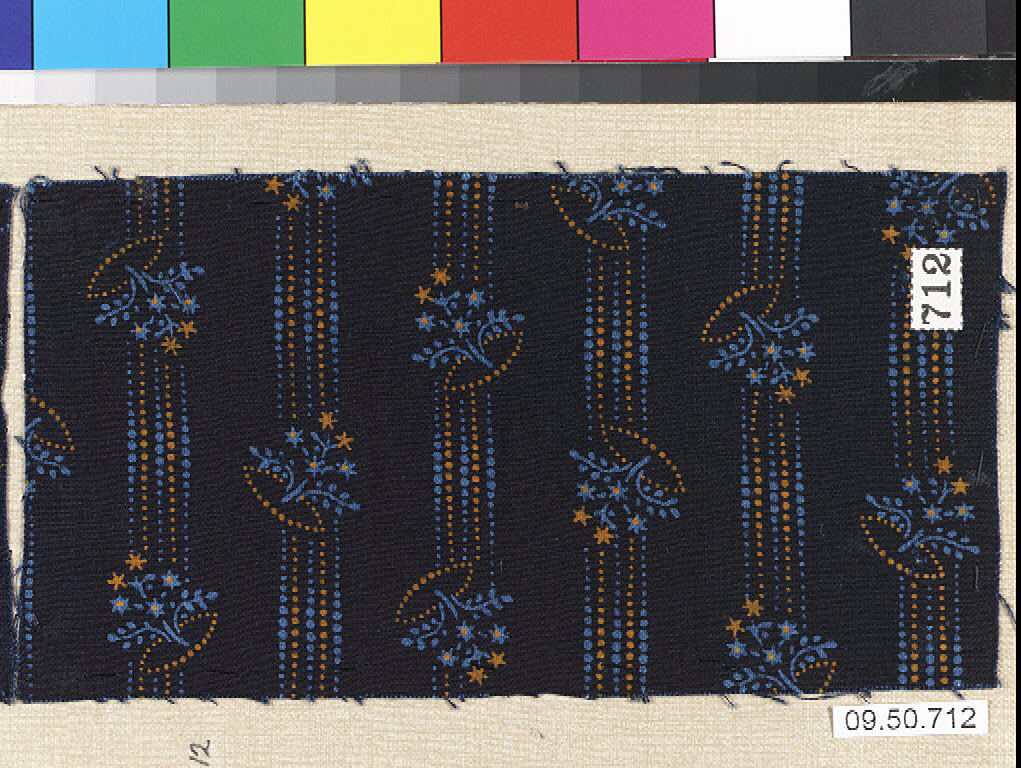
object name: piece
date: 1801-1900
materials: cotton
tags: flowers,leaves